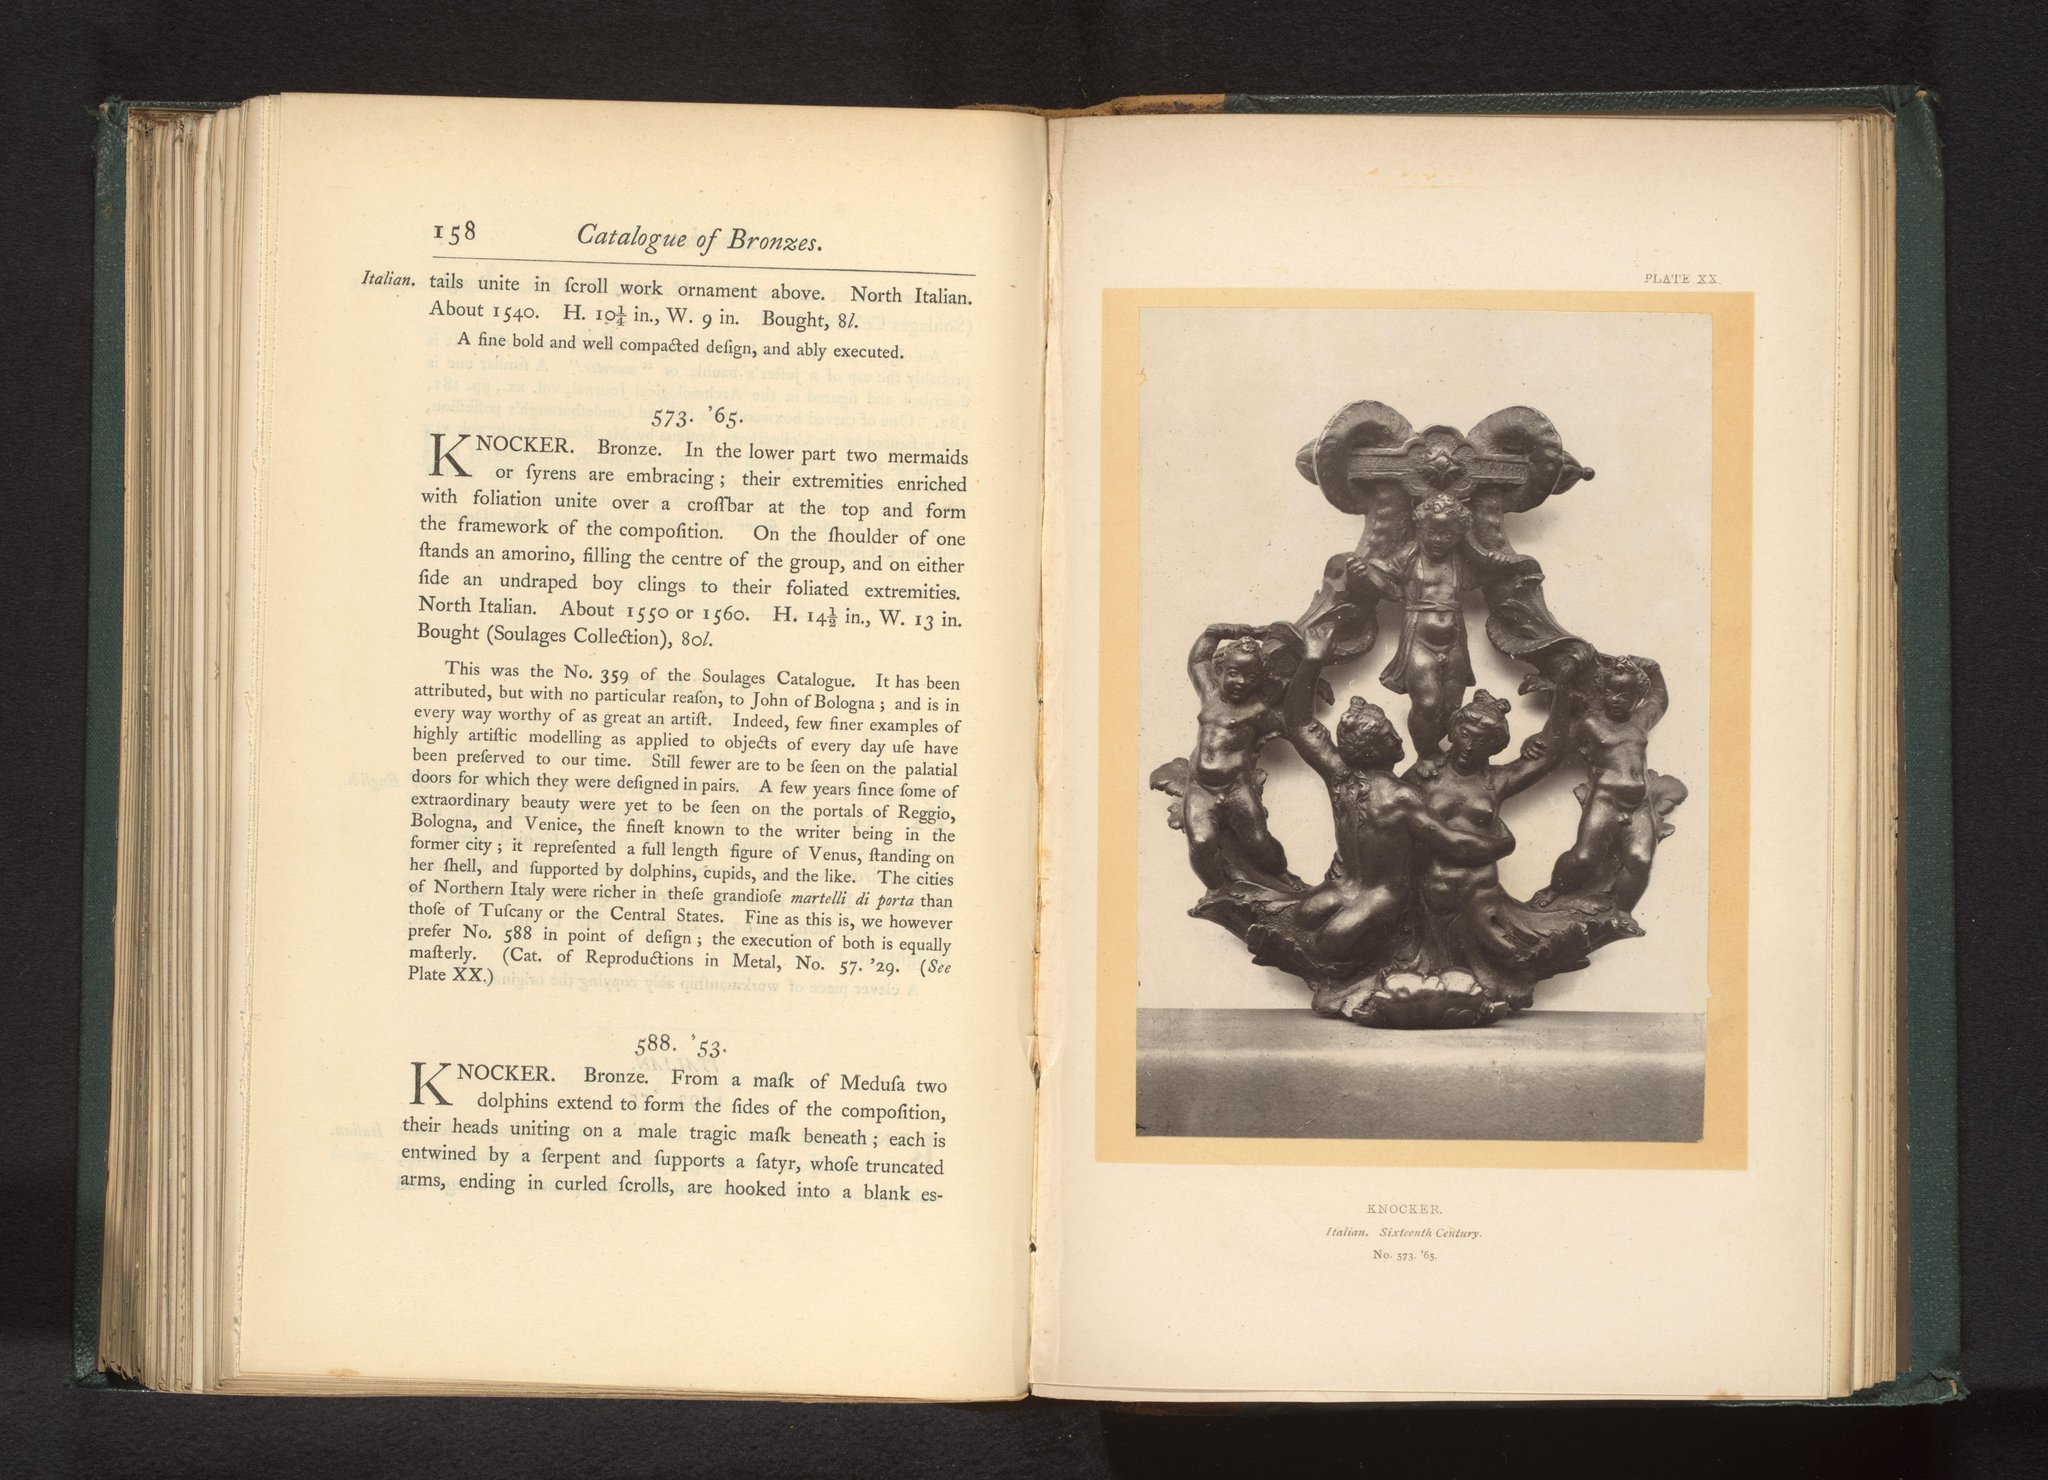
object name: page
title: Knocker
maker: Anonymous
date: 1869-1876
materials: paper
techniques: woodburytype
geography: london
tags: door-knocker, doorbell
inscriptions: inscription: ‘italian. Sixteenth Century.’, number: ‘No. 573. '65.’, number: ‘Plate XX.’